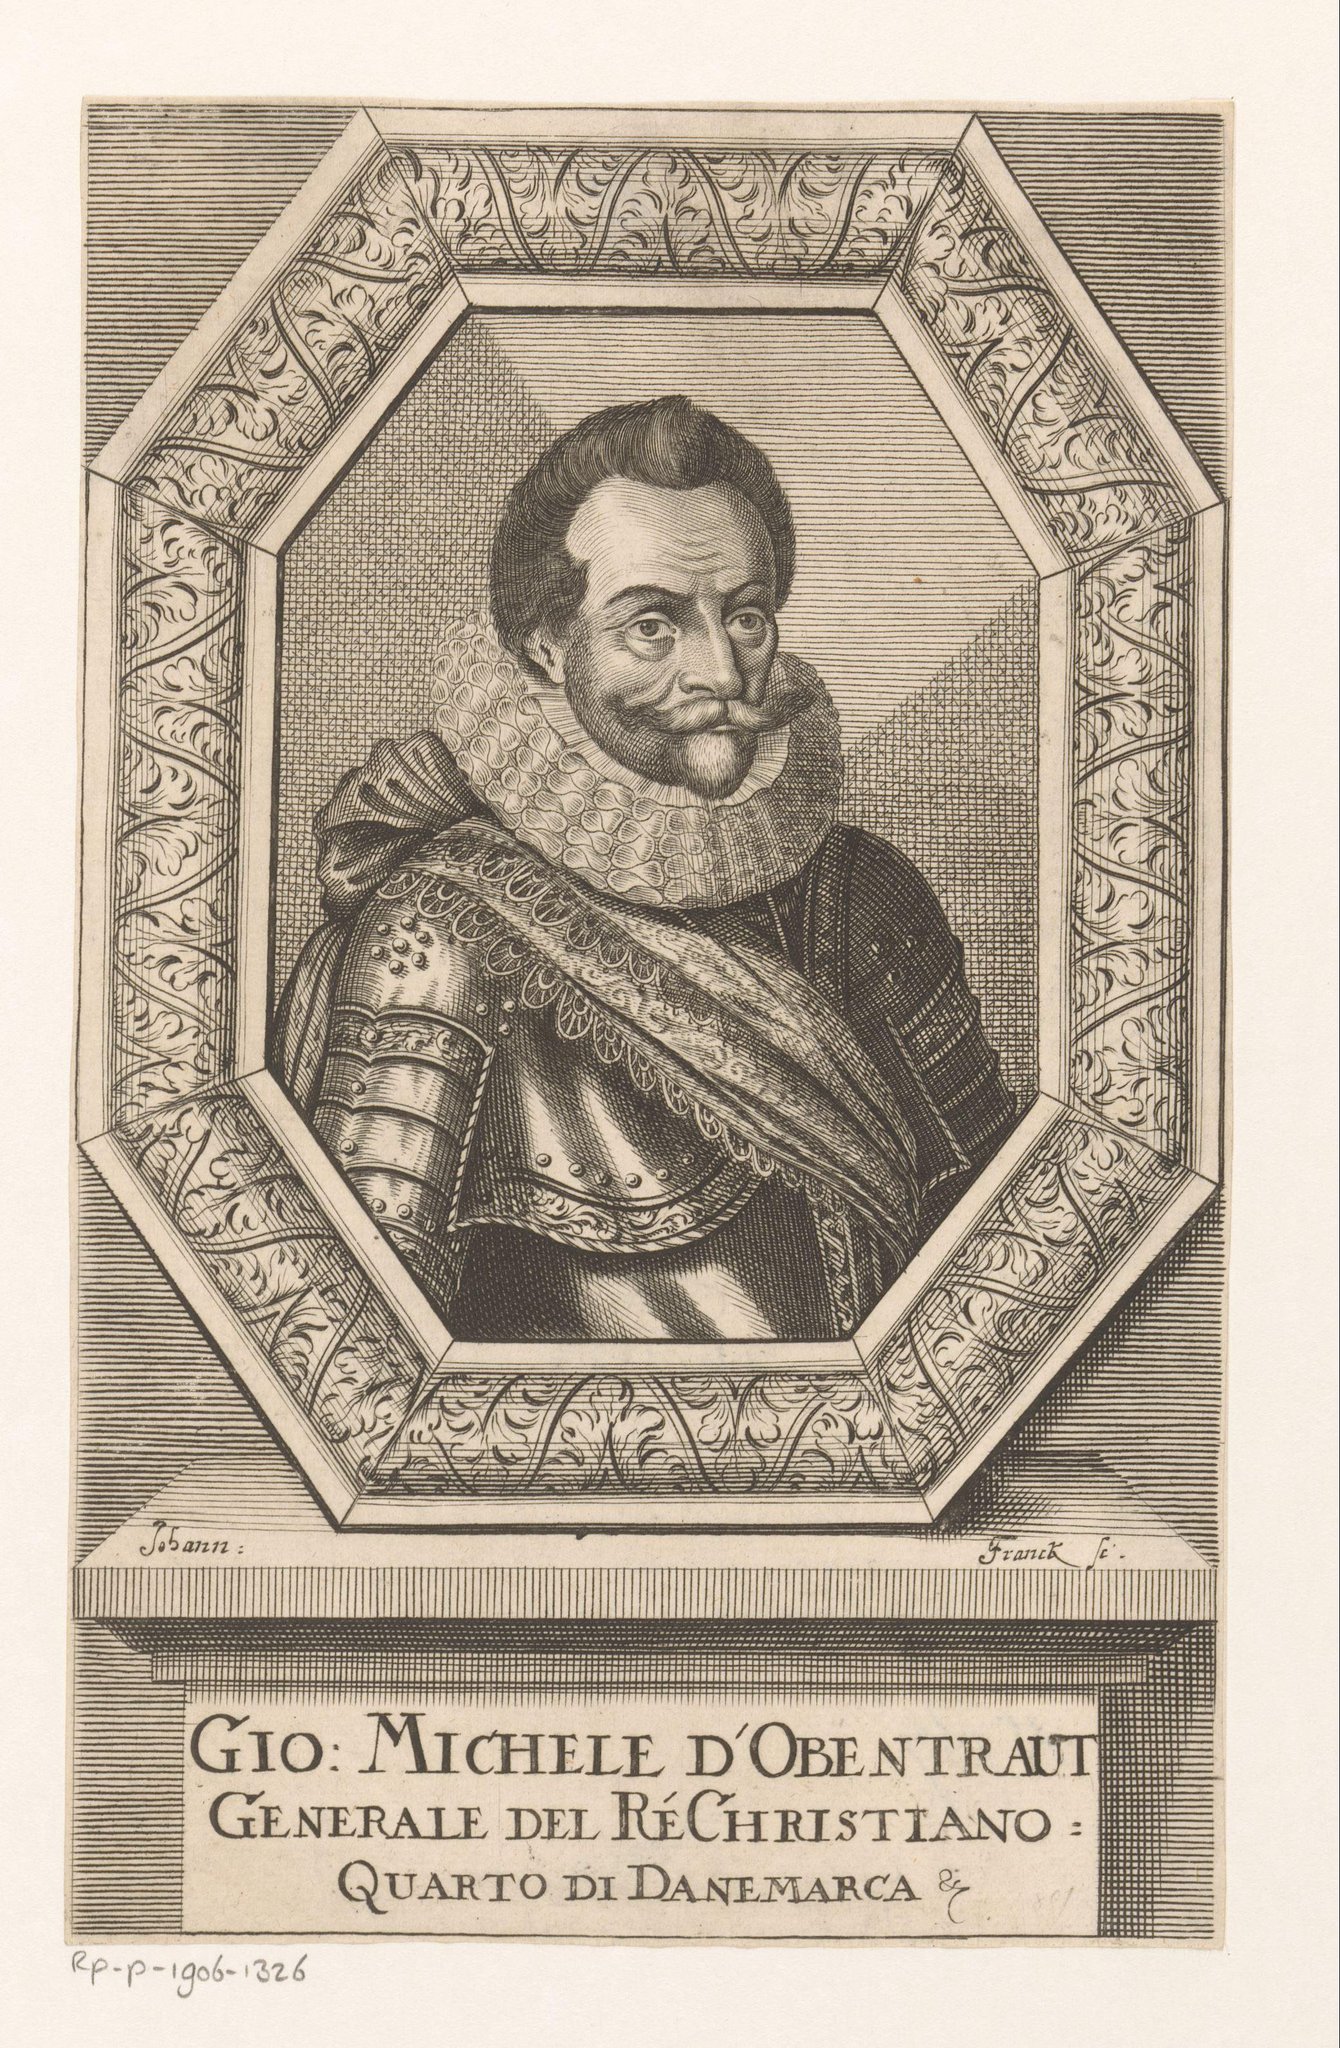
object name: print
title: Portret van Hans Michael Elias von Obentraut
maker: johann franck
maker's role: print maker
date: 1672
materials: paper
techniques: engraving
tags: armour, historical persons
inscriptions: collector's mark: Lugt 2228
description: Prent gebruikt voor: Priorato, Galeazzo Gualdo. Historia di Ferdinando terzo. Wenen: s.n., 1672.